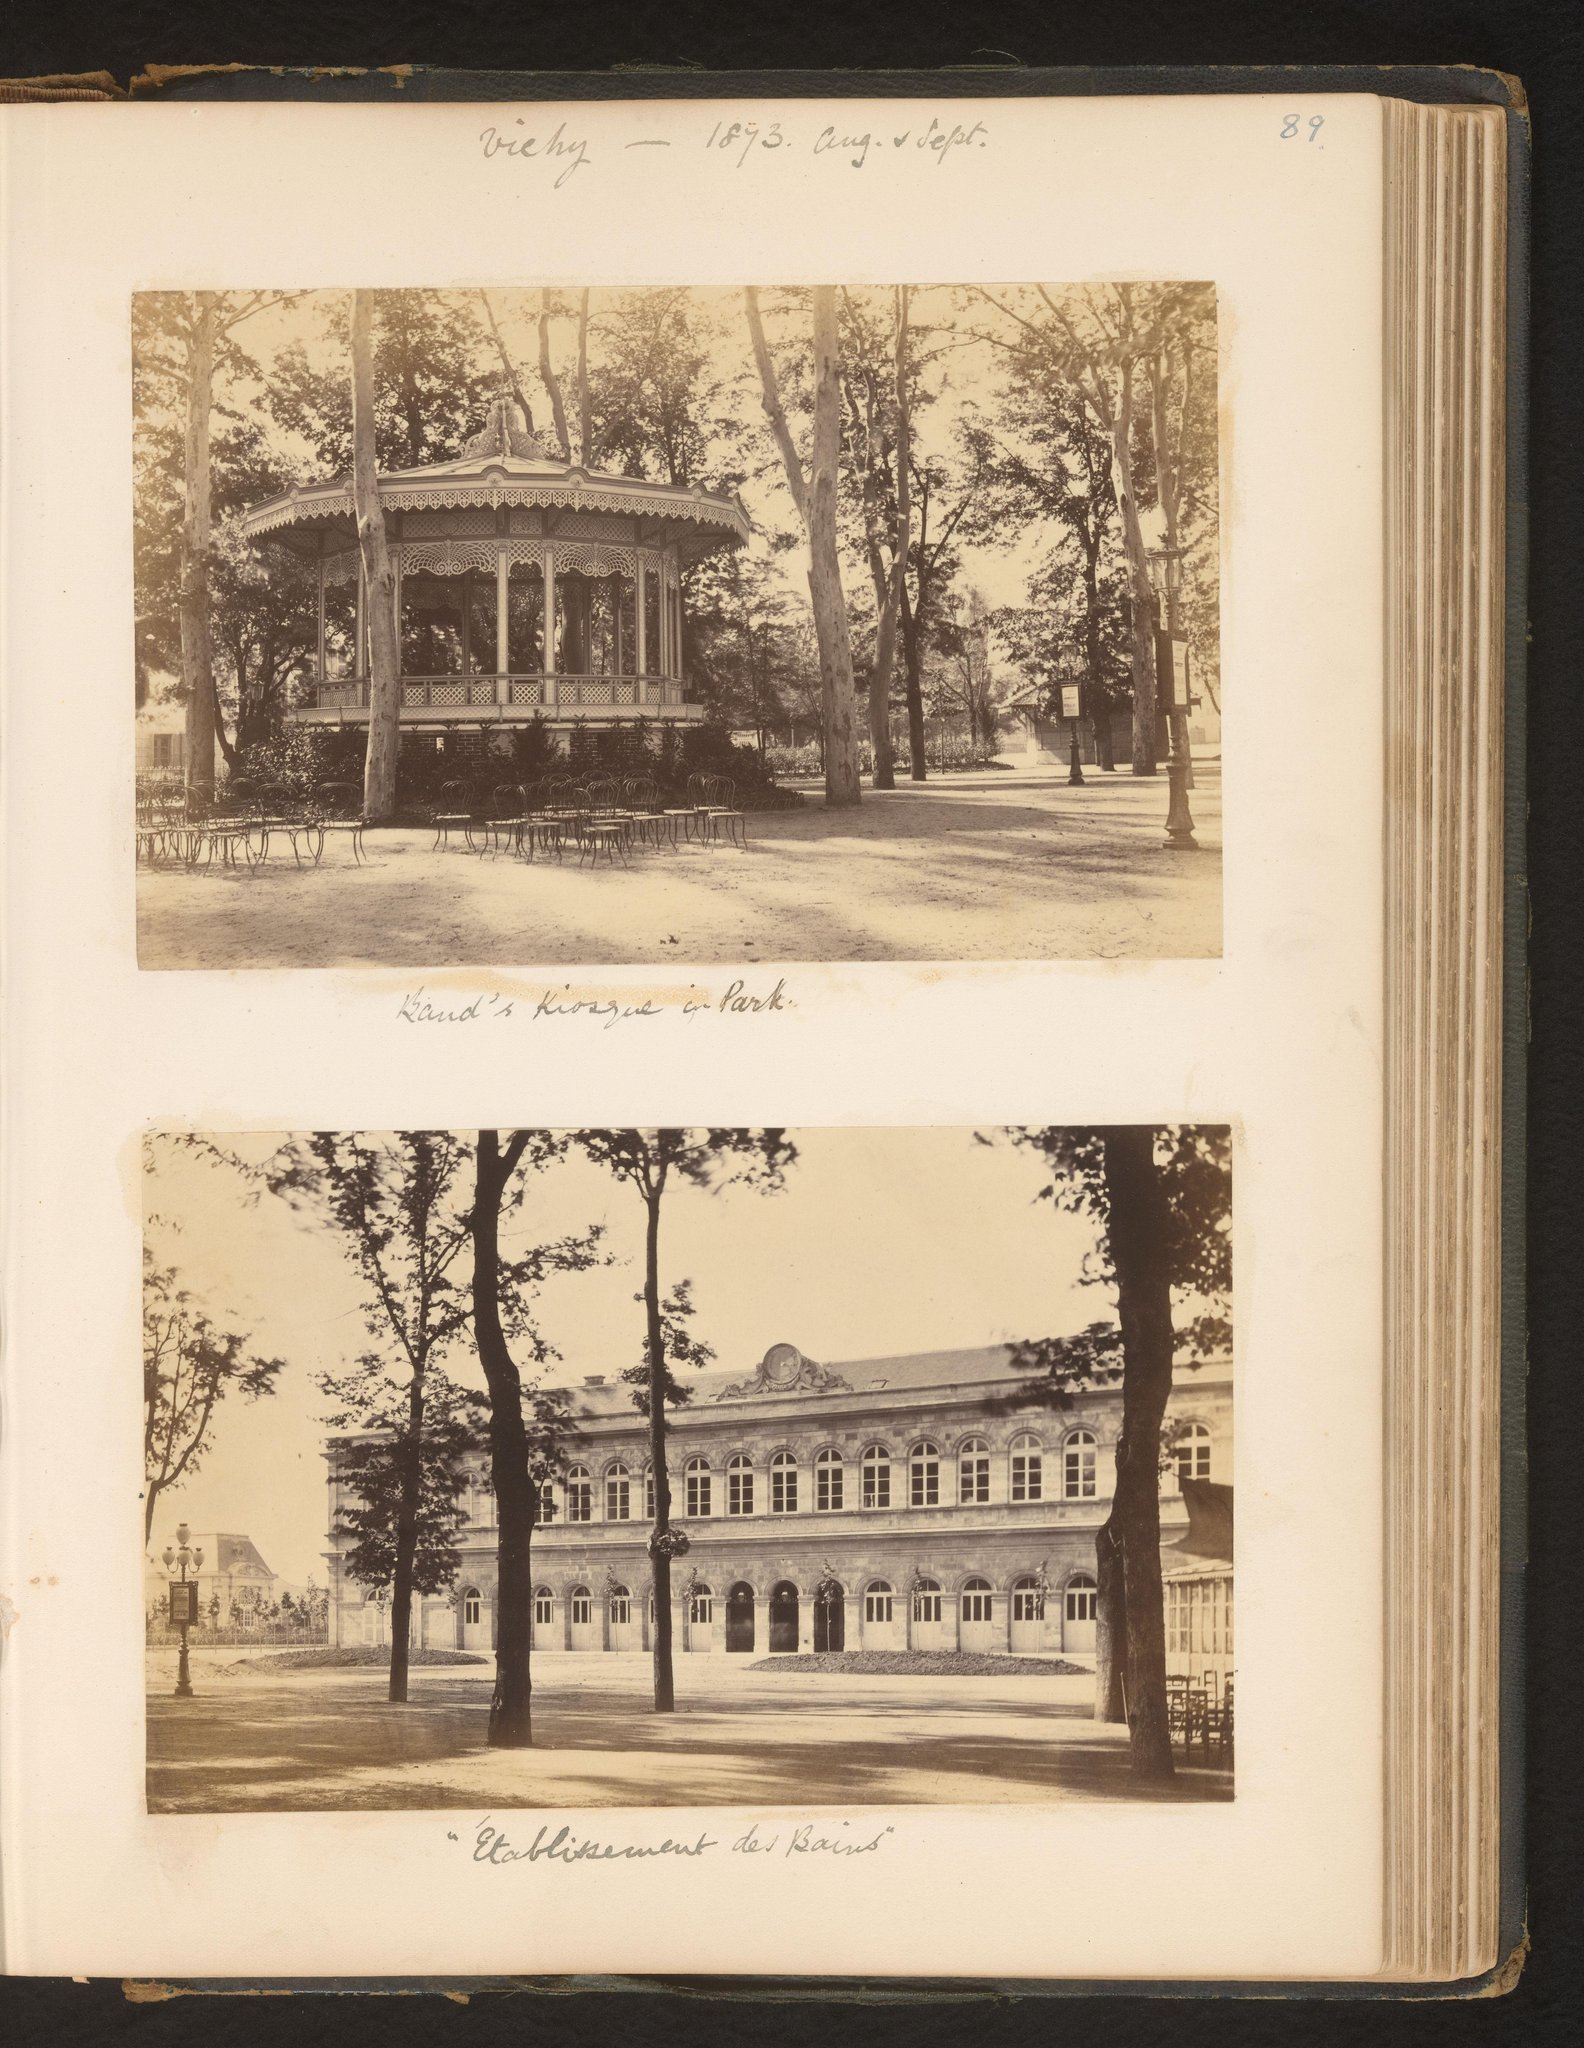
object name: photograph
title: Gezichten op Vichy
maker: Anonymous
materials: paper, photographic support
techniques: albumen print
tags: public gardens, park, front façade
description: Een kiosk in het park en een badhuis te Vichy. Deze pagina maakt deel uit van een album.